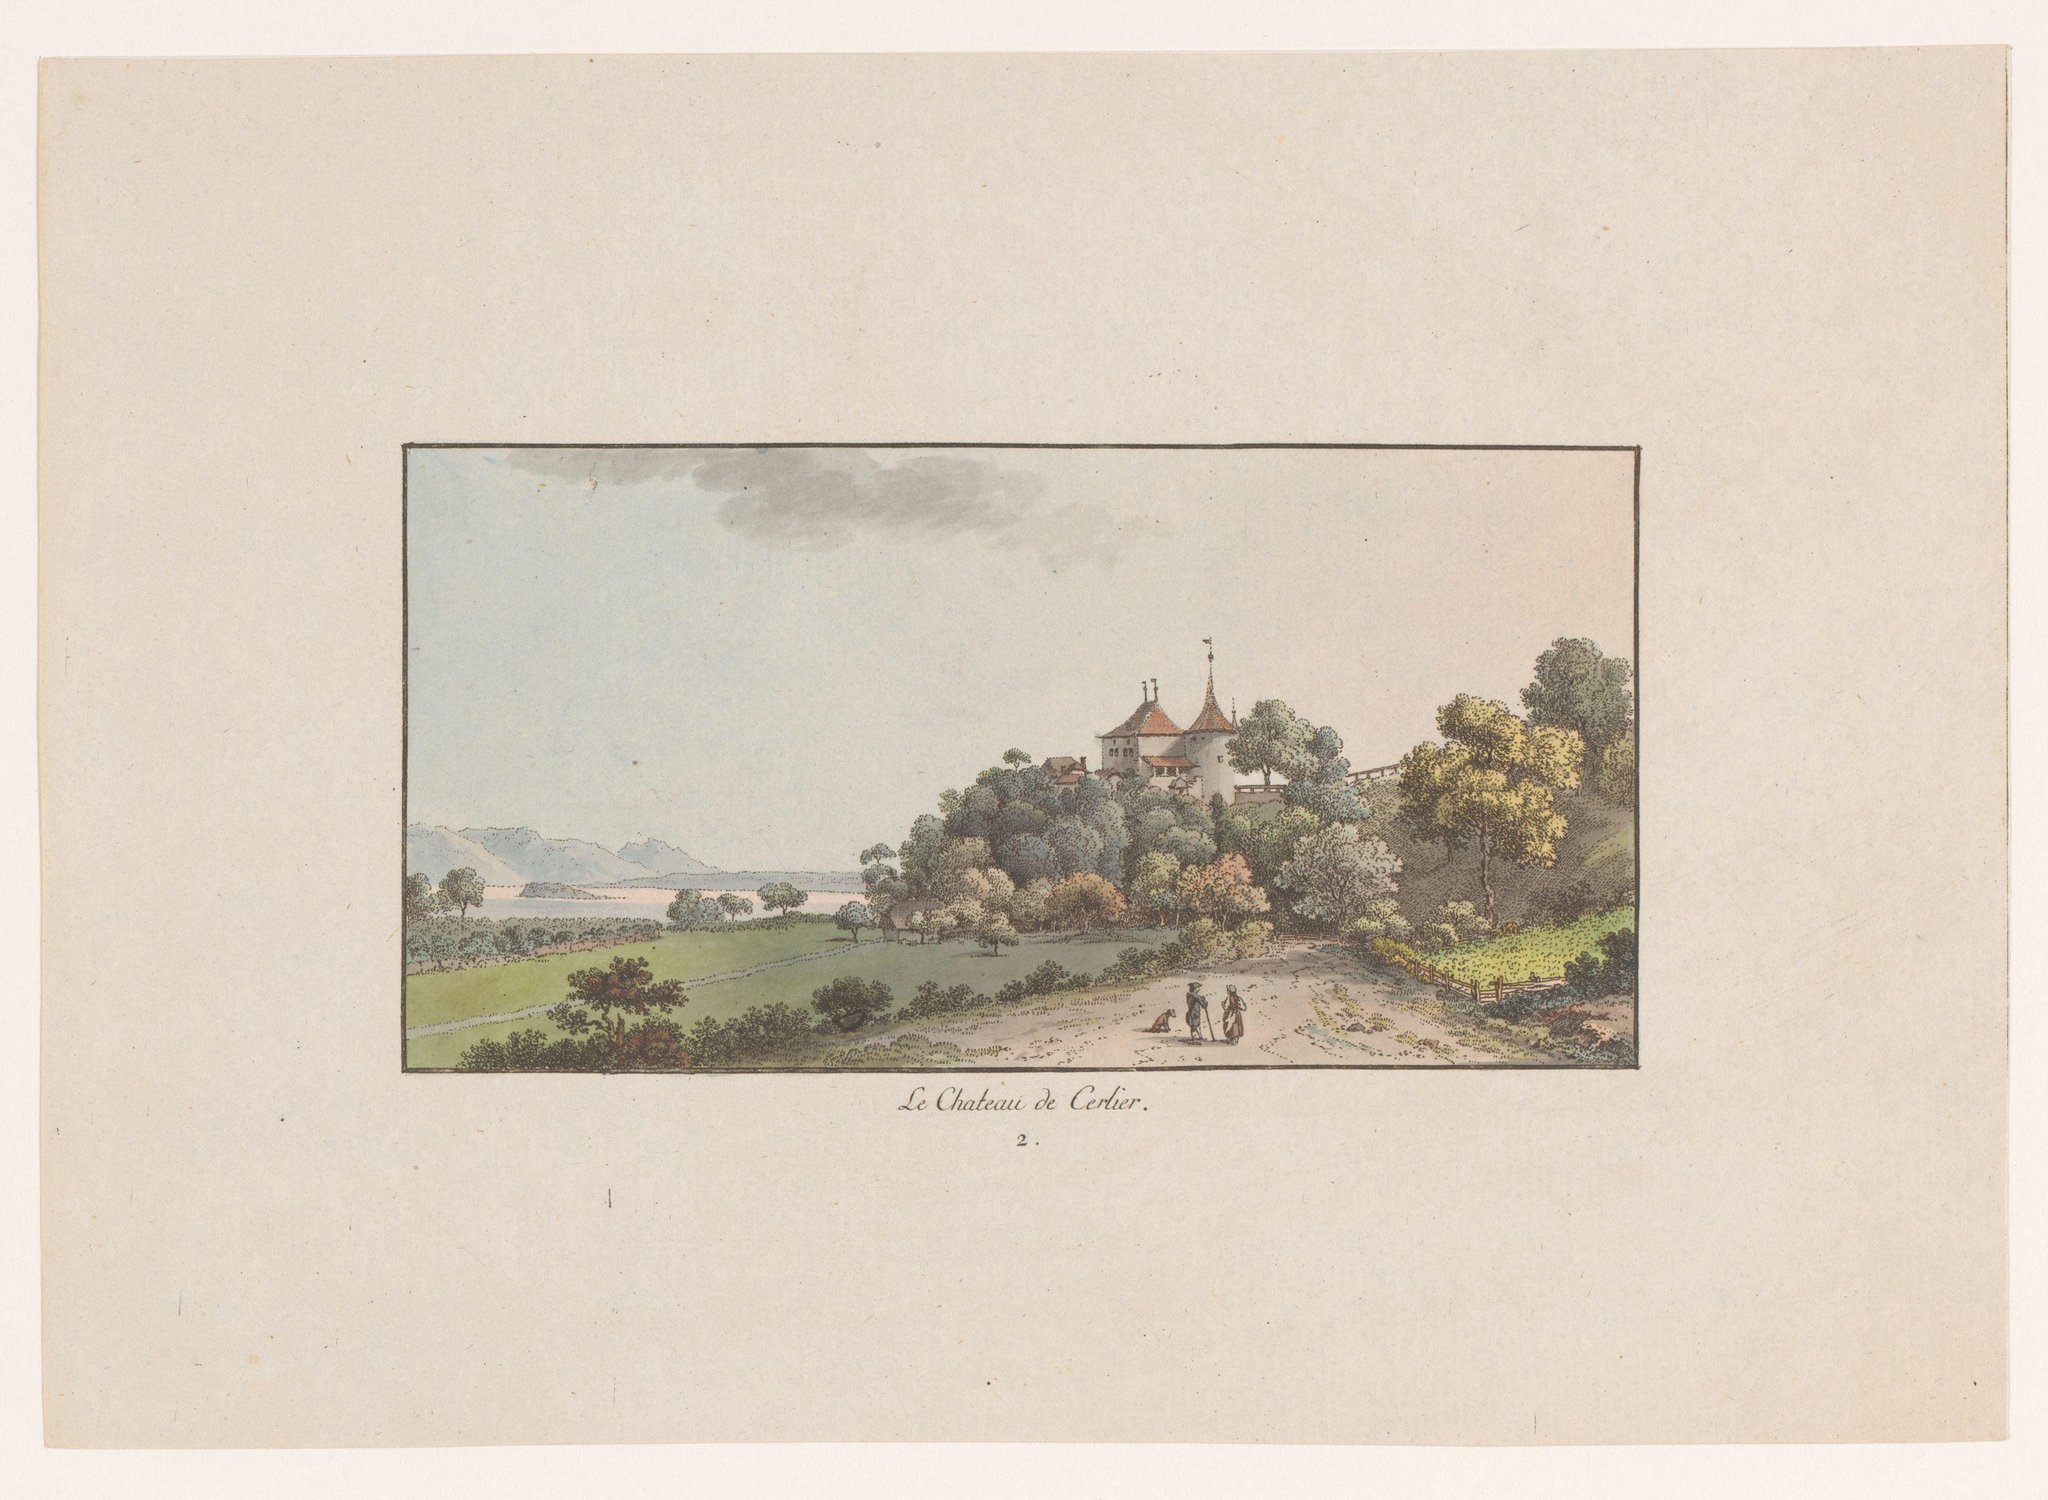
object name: print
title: Gezichten op Zwitserland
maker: johann ludwig aberli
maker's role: print maker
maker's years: 1723-1786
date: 1782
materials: paper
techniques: etching, hand coloring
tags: civic architecture; edifices; dwellings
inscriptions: collector's mark: Lugt 2228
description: Maakt deel uit van een serie met gezichten op Zwitserland.